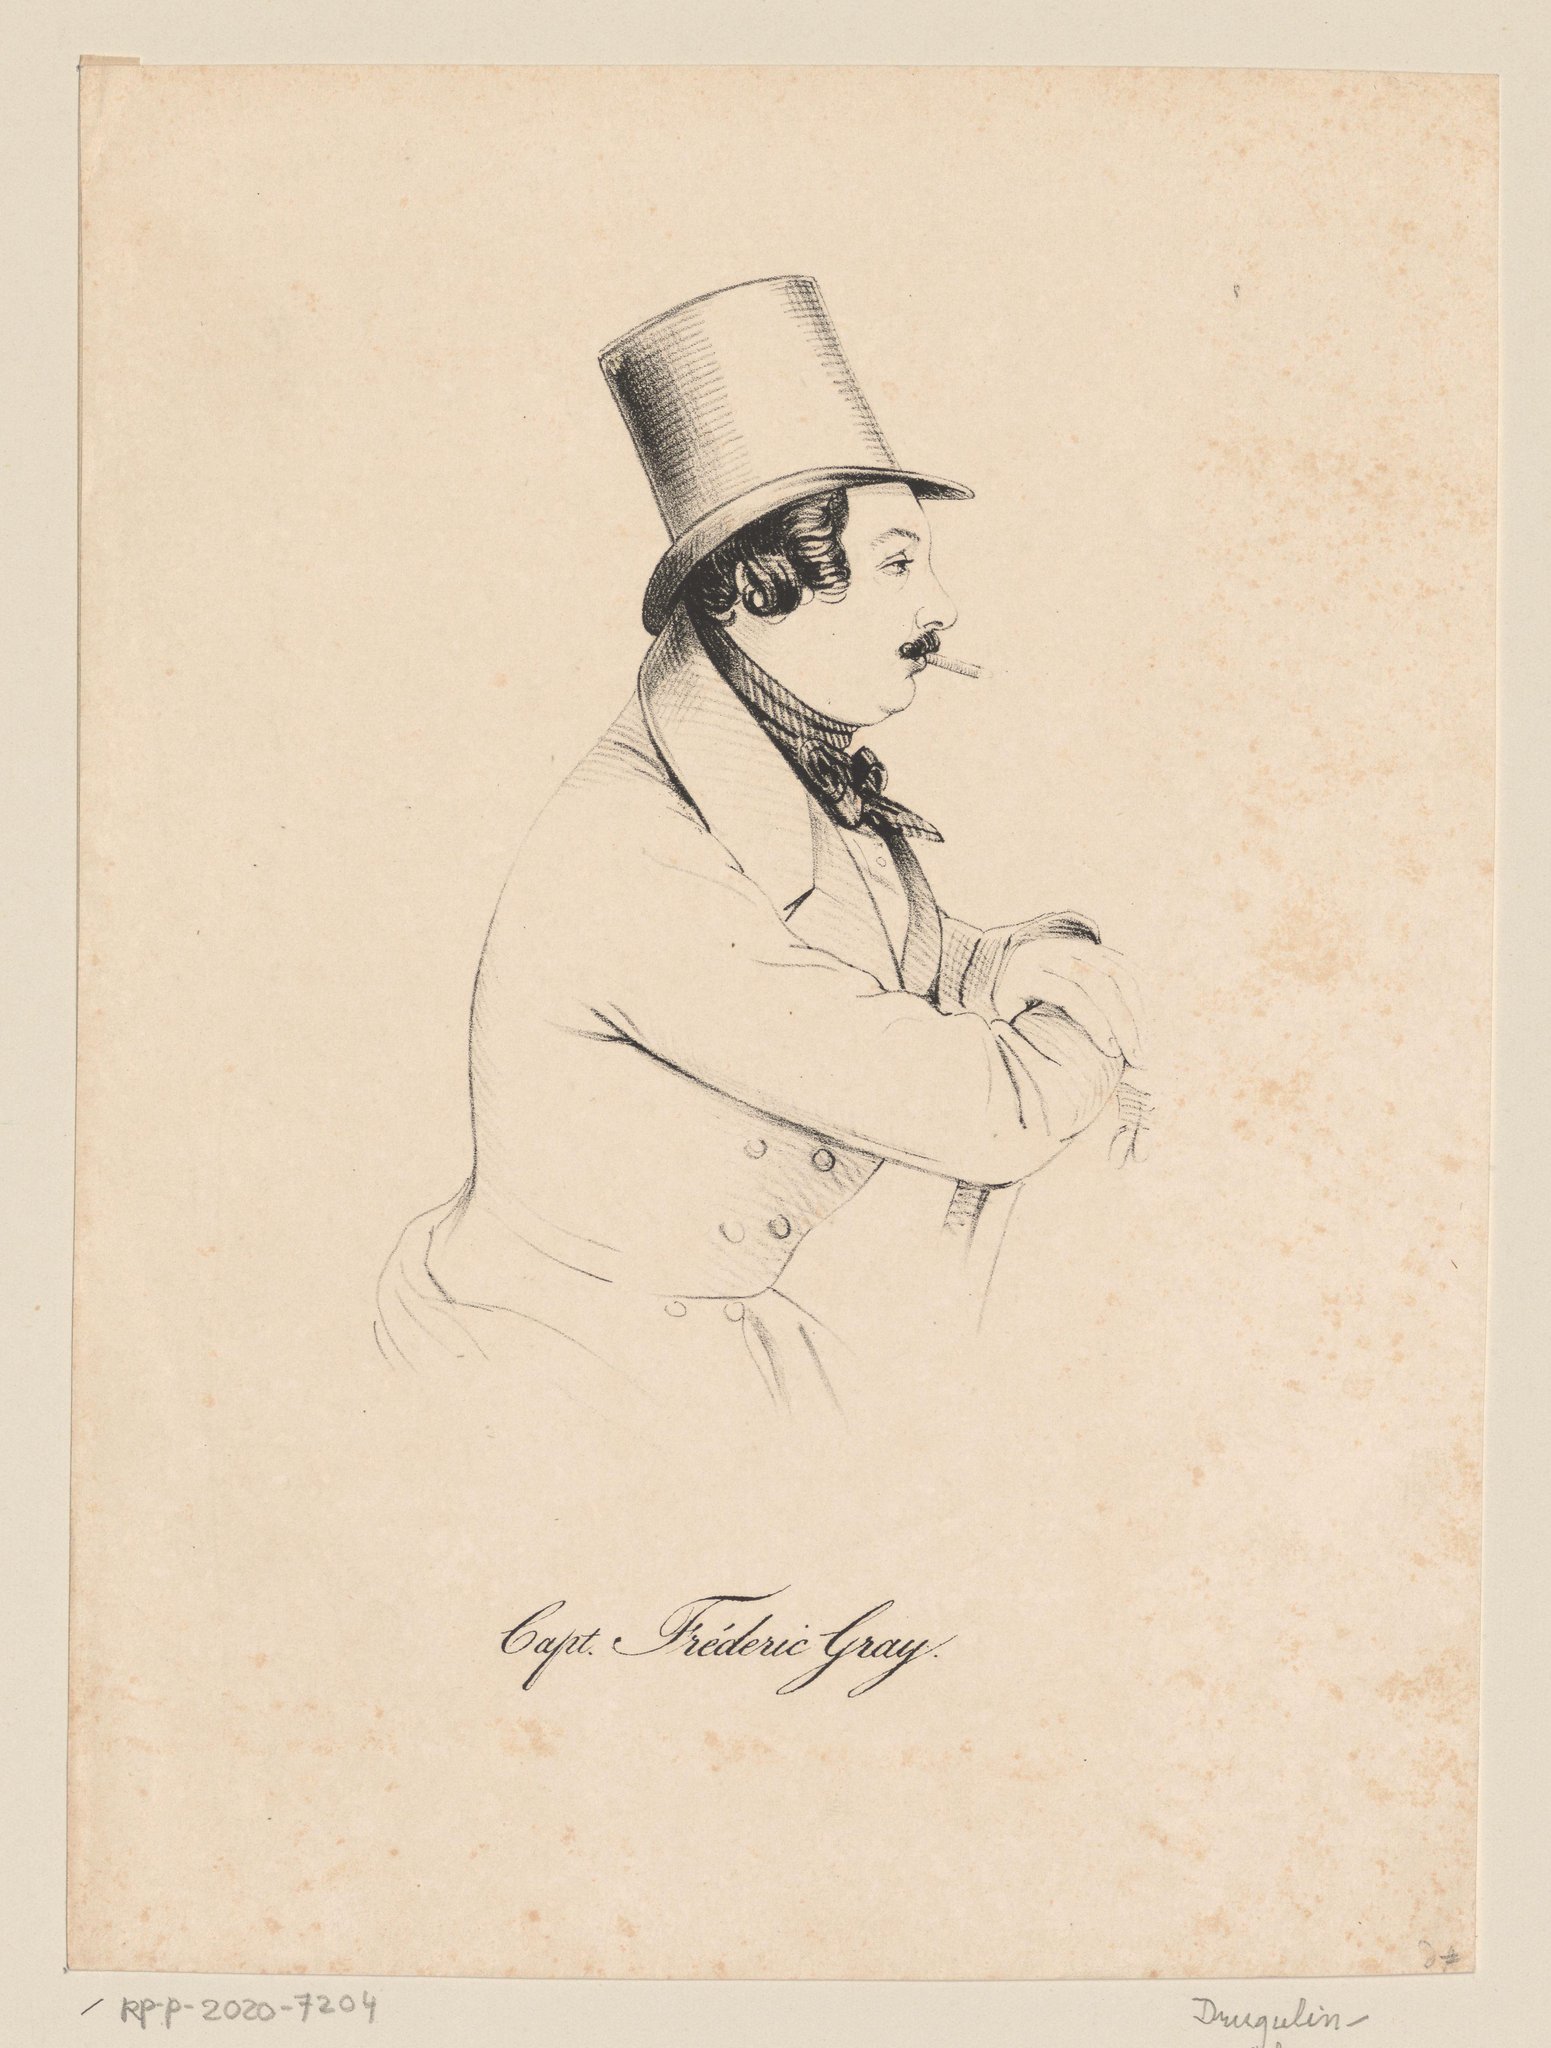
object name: print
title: Portret van Fréderic Gray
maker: Anonymous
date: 1800-1900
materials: paper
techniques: lithograph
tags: historical persons